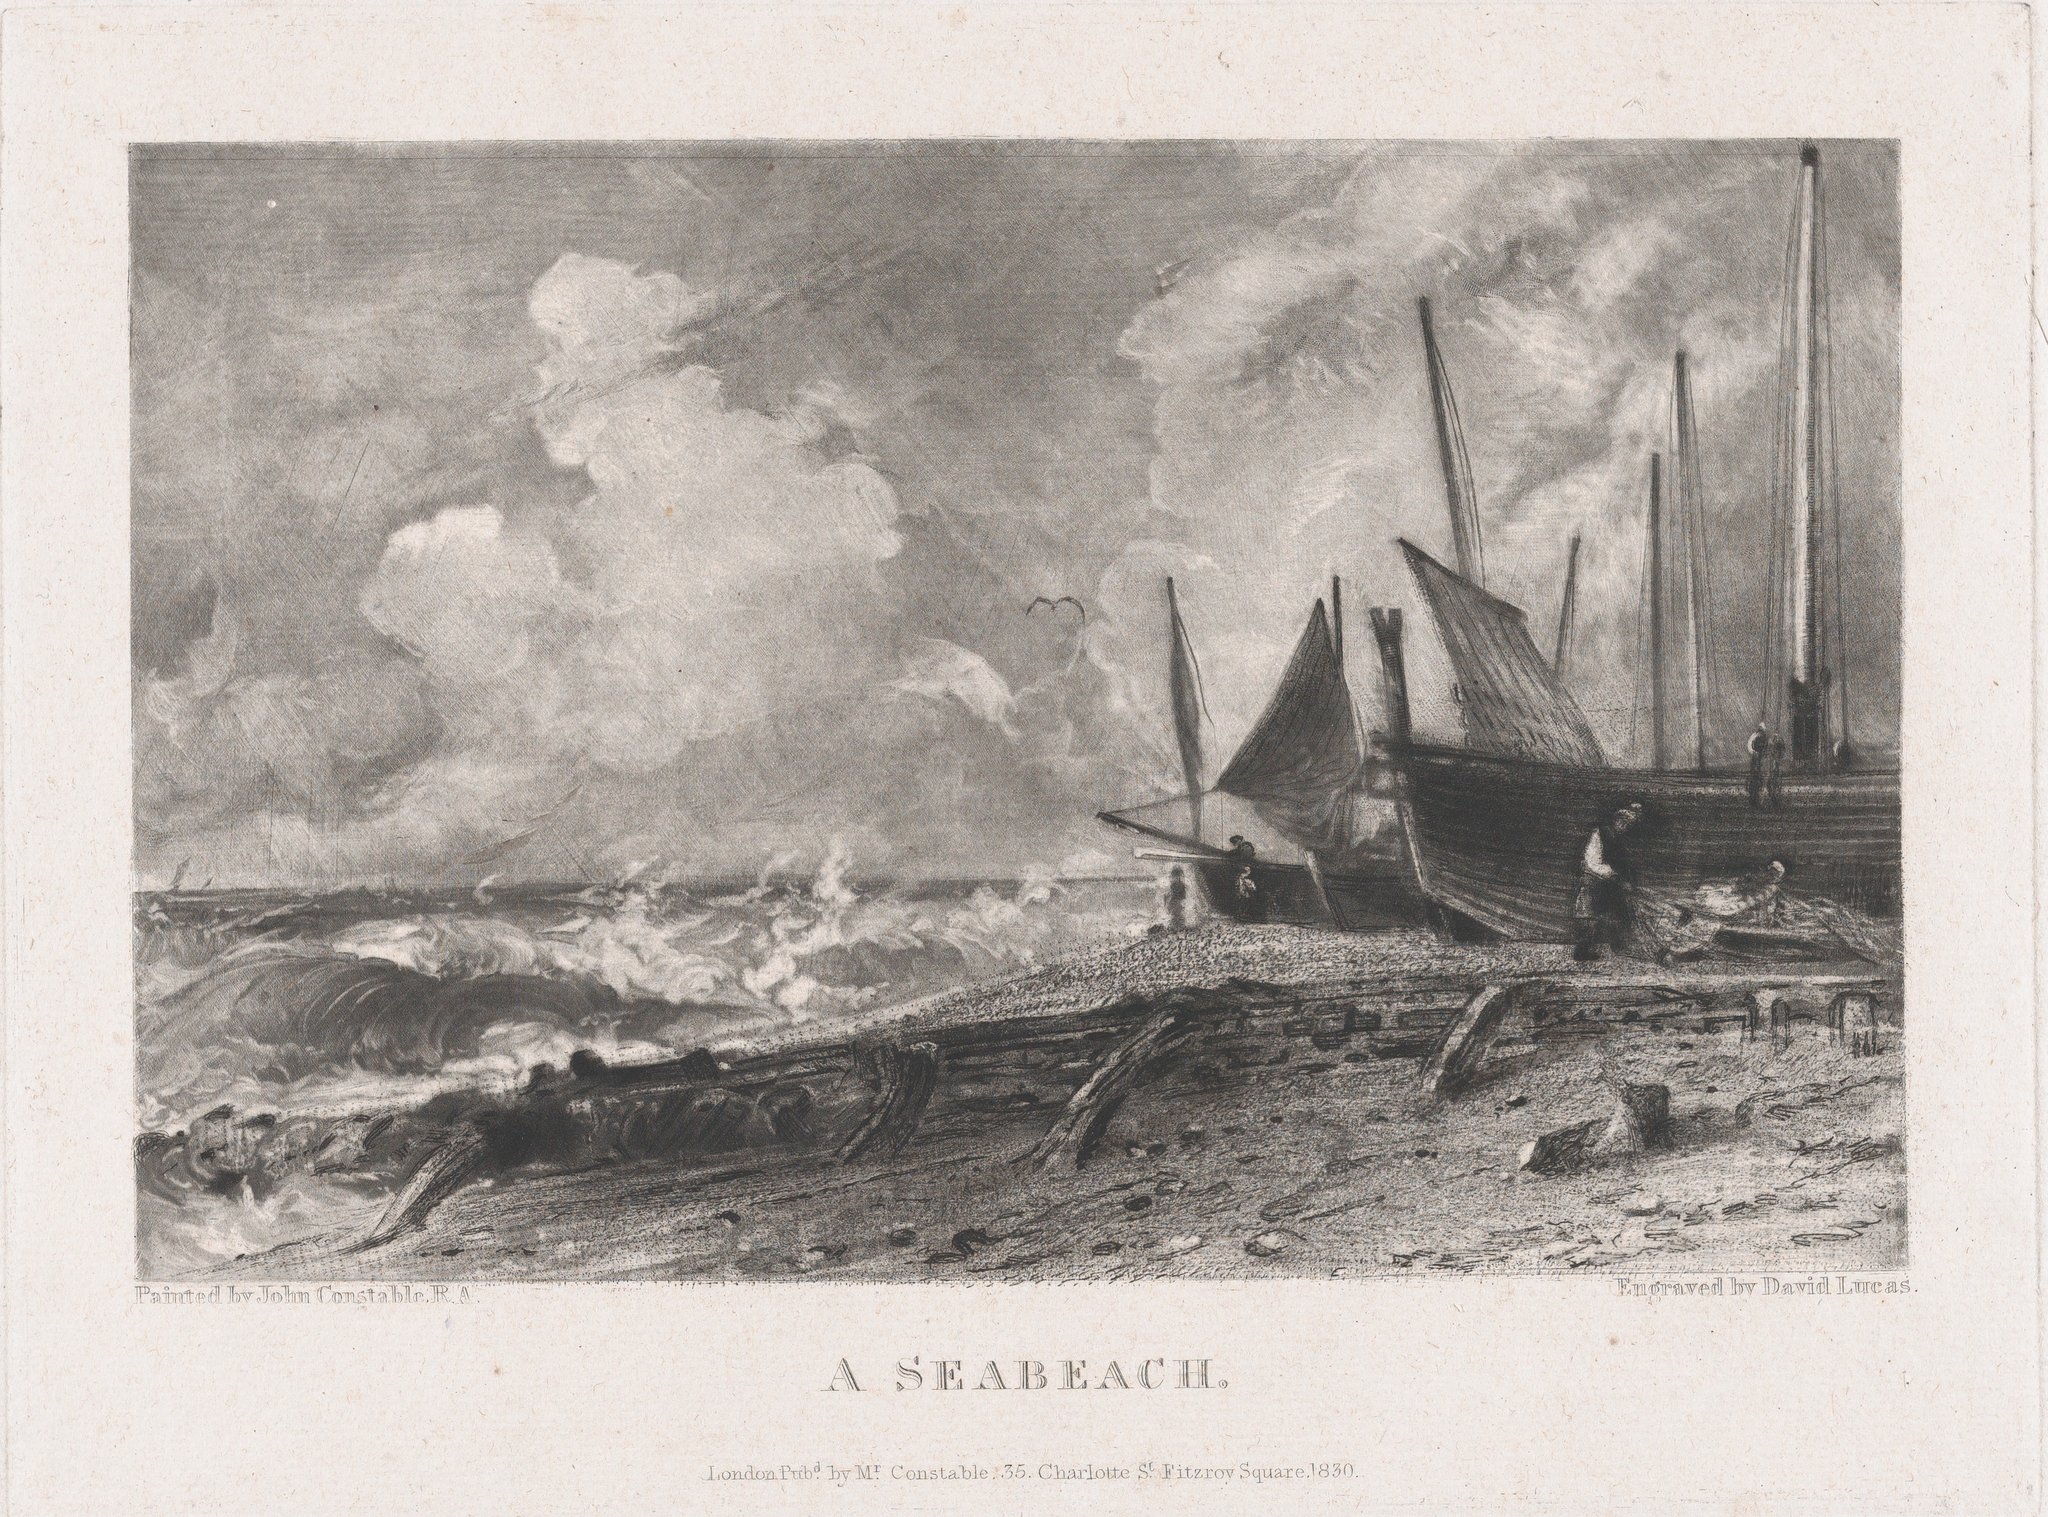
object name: print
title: A Sea Beach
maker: david lucas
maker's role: artist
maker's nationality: british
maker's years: 1802-1881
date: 1830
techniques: mezzotint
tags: boats